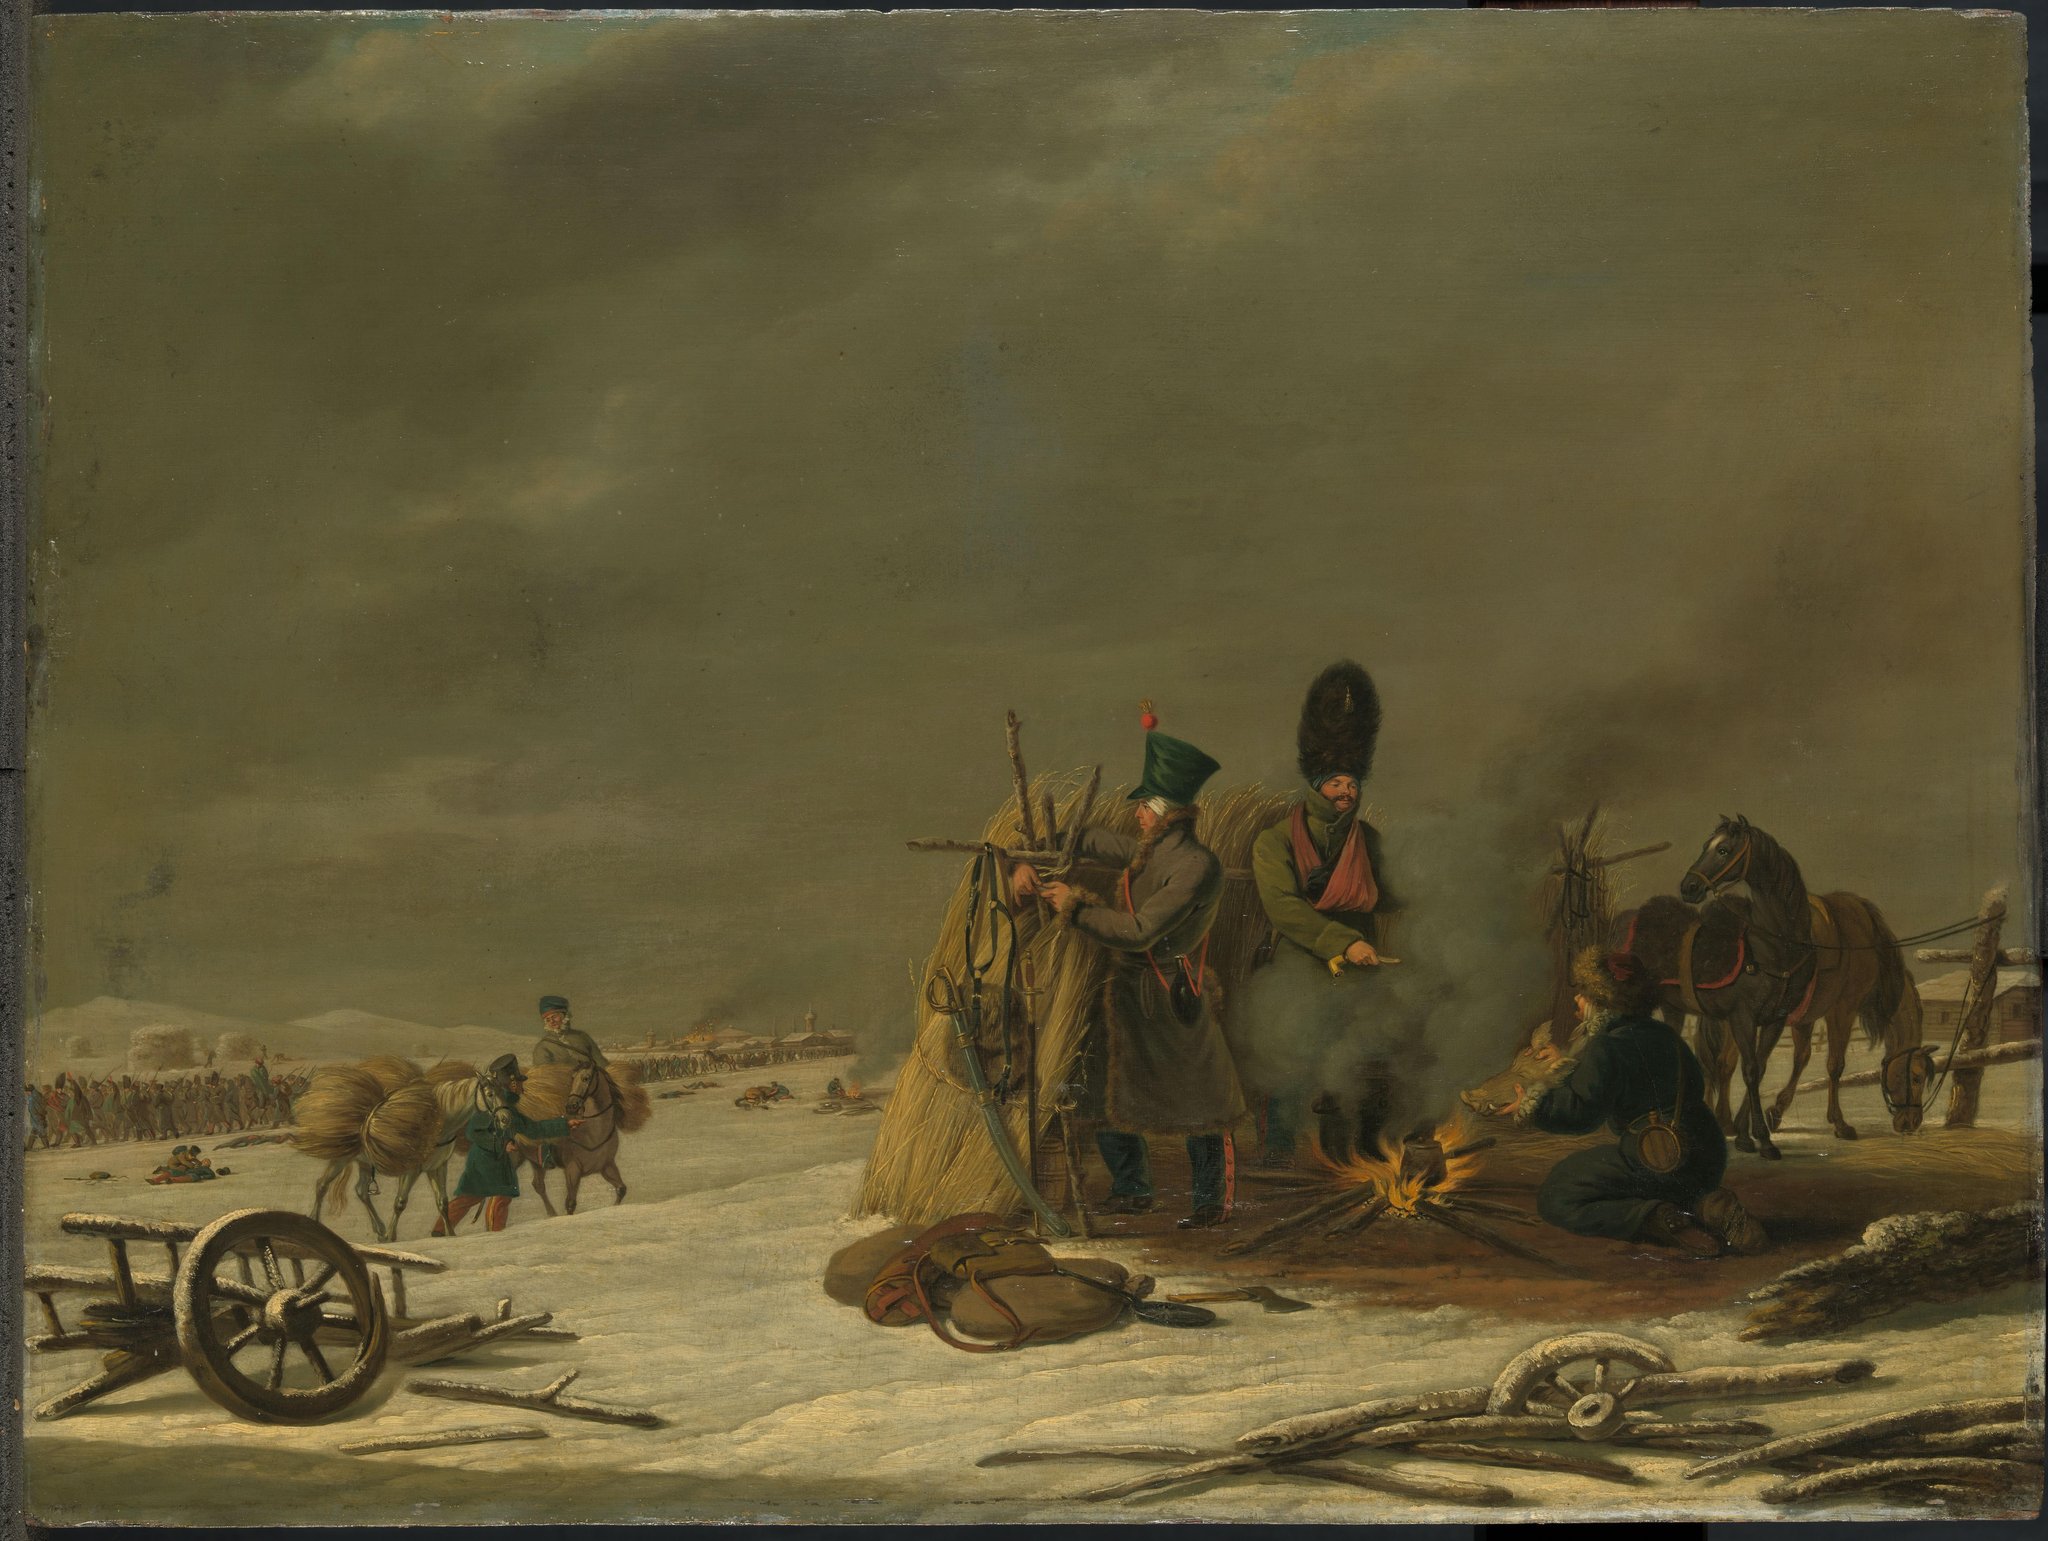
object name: painting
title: Bivouac at Molodechno, 3-4 December 1812: an episode from Napoleon's Retreat from Russia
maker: johannes hari (i)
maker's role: draughtsman, painter, print maker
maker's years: 1772-1849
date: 1816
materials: oil, panel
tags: (military) camp with tents, retreat of the defeated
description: Nachtkwartier te Molodetschno (Maladzetsjna), 3-4 december 1812: episode uit de terugtocht van keizer Napoleon uit Rusland. Een nachtverblijf zoals gebruikt door de beide eerste luitenants W.P. d'Auzon de Boisminart en diens zwager A. de Groot Stiffry. Soldaten schuilen bij een provisorische beschutting van riet bij een kampvuur, rechts de paarden. Bij het vuur knielt een man met een varkenskop in zijn handen. Links lopen de Franse soldaten in lange rijen door de sneeuw.